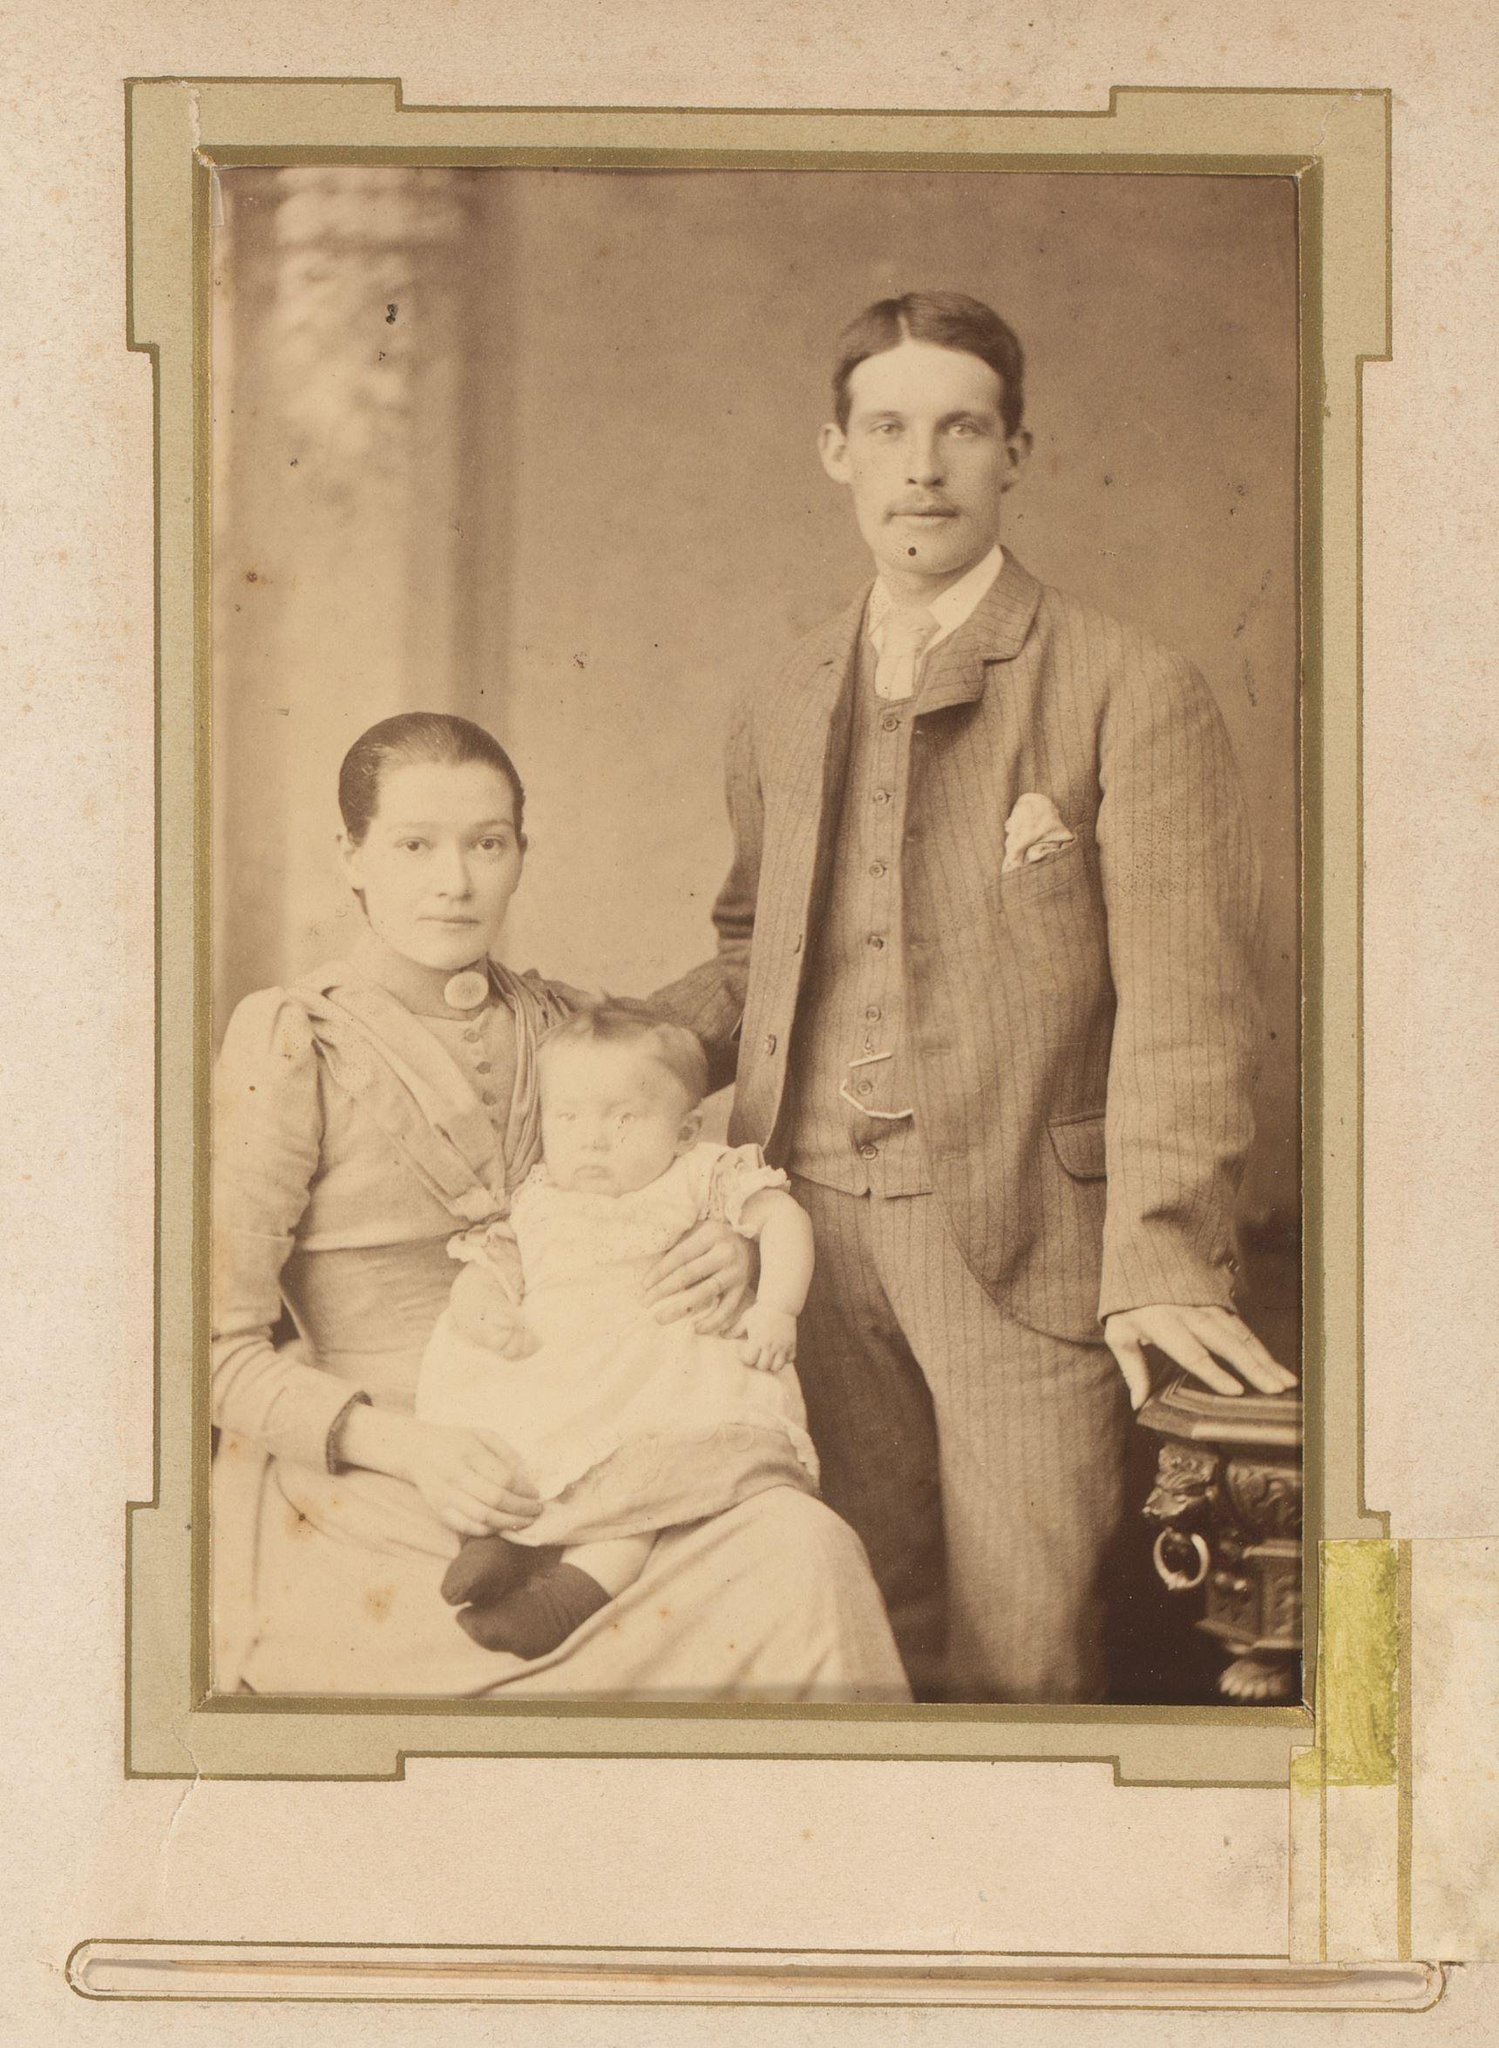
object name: cabinet photograph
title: Familieportret van een man, vrouw en baby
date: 1860-1900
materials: cardboard, photographic support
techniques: albumen print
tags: adult woman, parents with their children, adult man, child, historical persons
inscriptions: inscription: ‘Chruch & Brantingham/ photographic artists/ 119/ High St/ Sunderland’